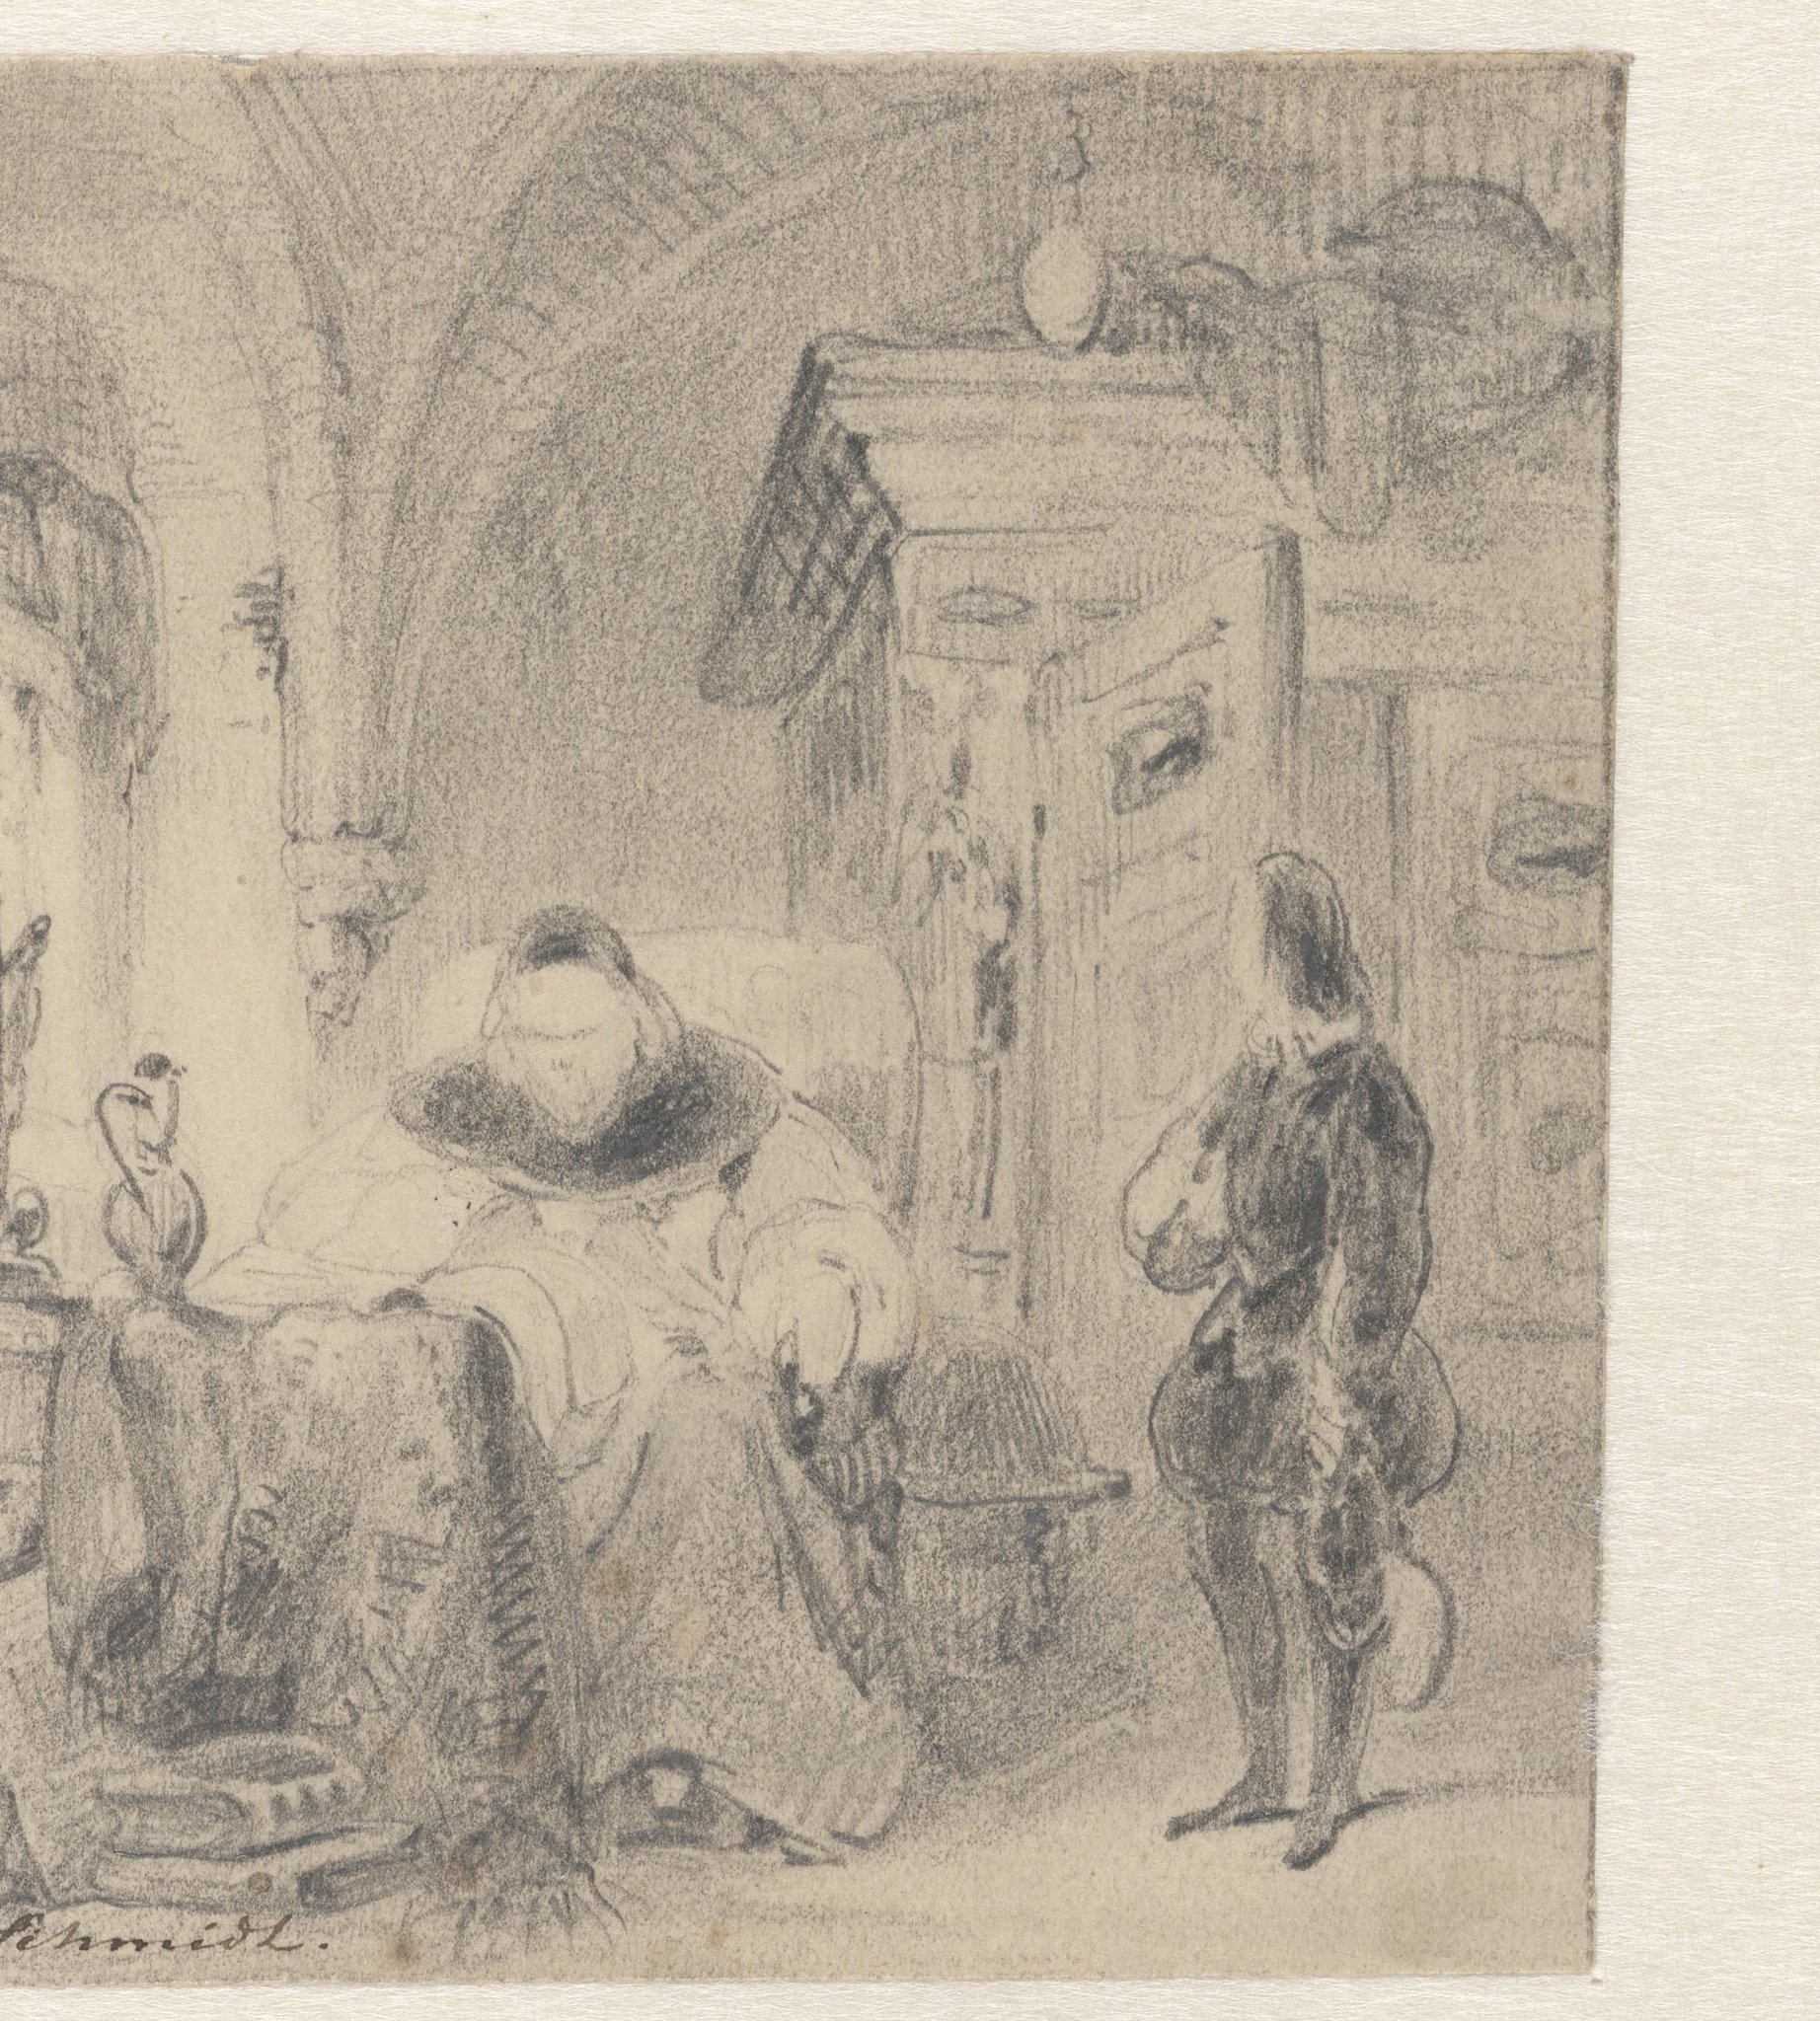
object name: drawing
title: Geestelijke die een brief leest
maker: willem hendrik schmidt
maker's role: draughtsman, painter, print maker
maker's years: 1809-1849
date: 1819-1849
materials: paper, pencil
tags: interior of the house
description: In een gewelfd interieur zit een geestelijke aan het raam een brief te lezen die een page heeft gebracht.